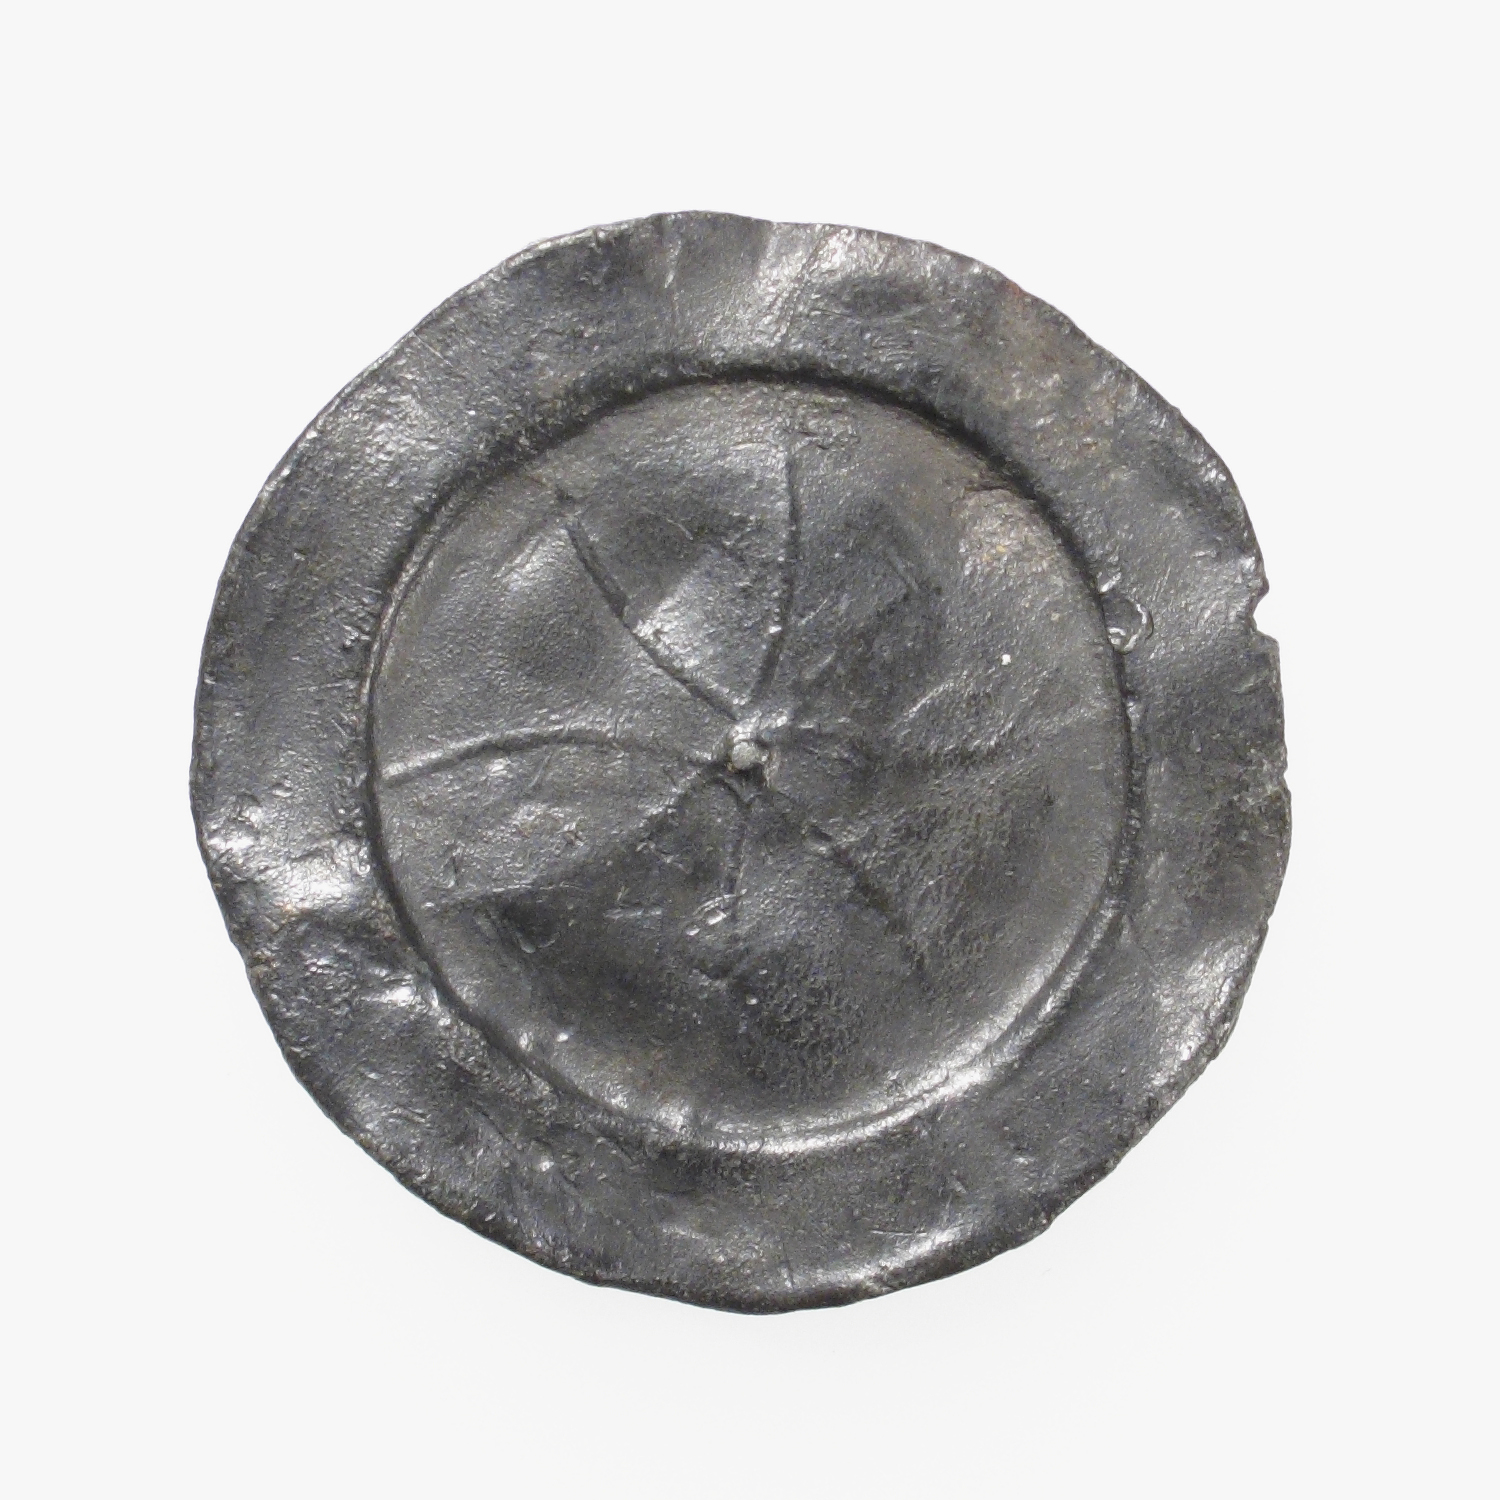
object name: pilgrim's badge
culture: french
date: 1301-1600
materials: lead